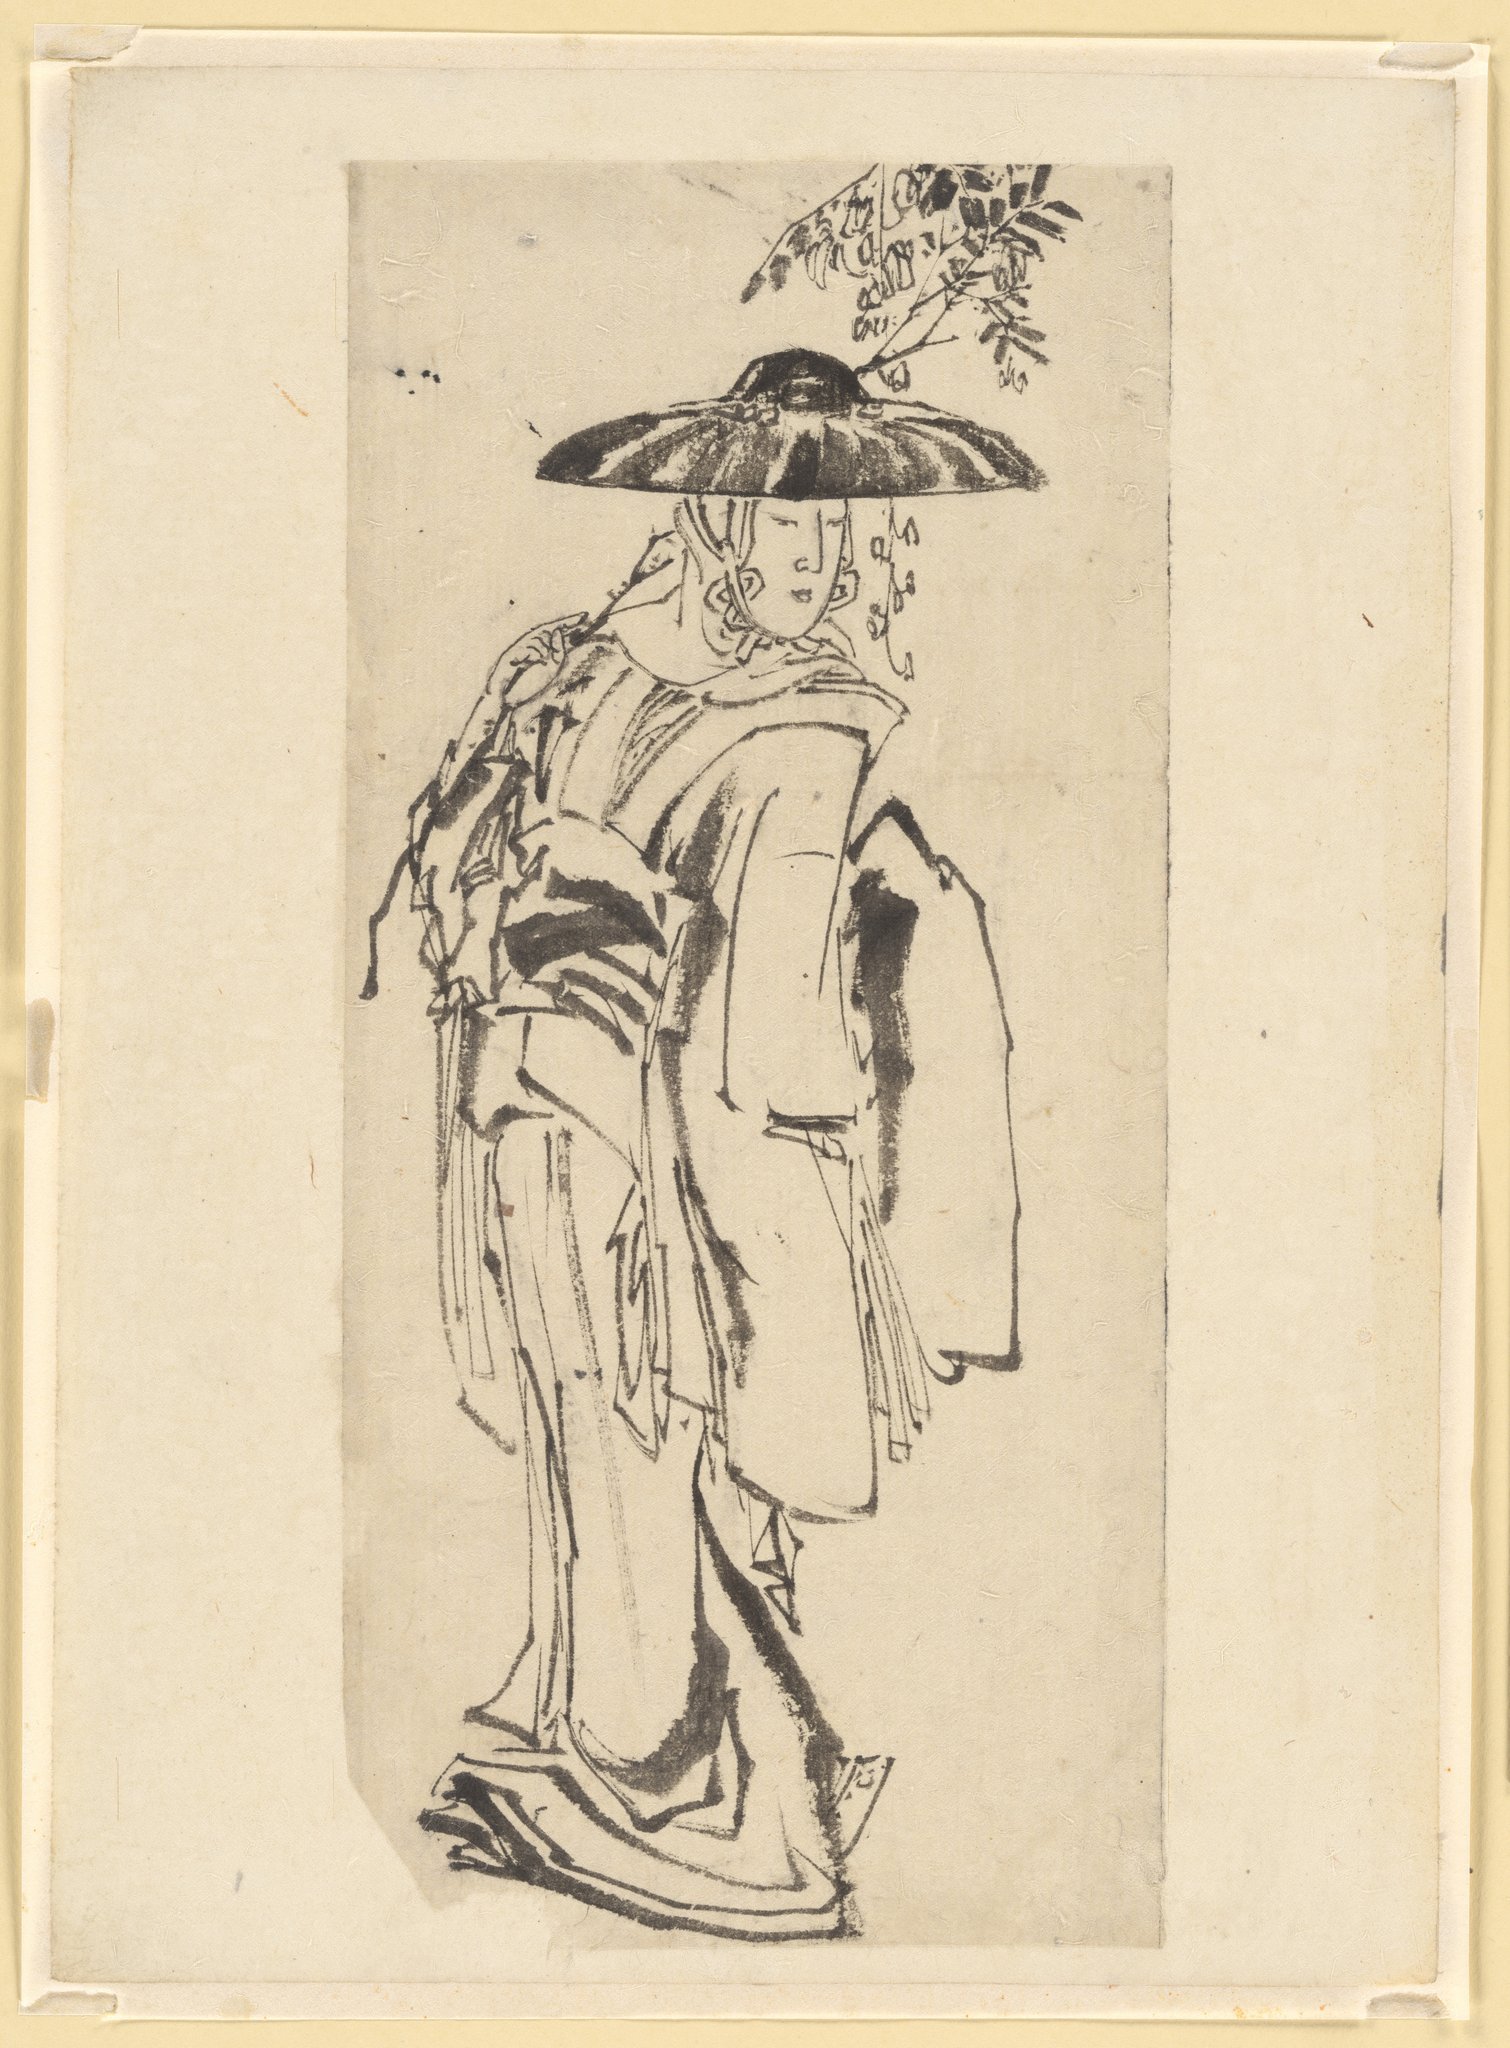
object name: drawing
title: Fuji Musume, the Wisteria Maid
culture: japanese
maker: katsushika hokusai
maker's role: artist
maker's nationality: japanese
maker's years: 1760-1849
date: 1701-1900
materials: ink, paper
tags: women